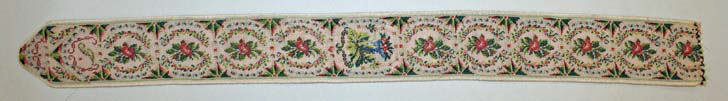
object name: suspender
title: Suspenders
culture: european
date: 1801-1900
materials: silk